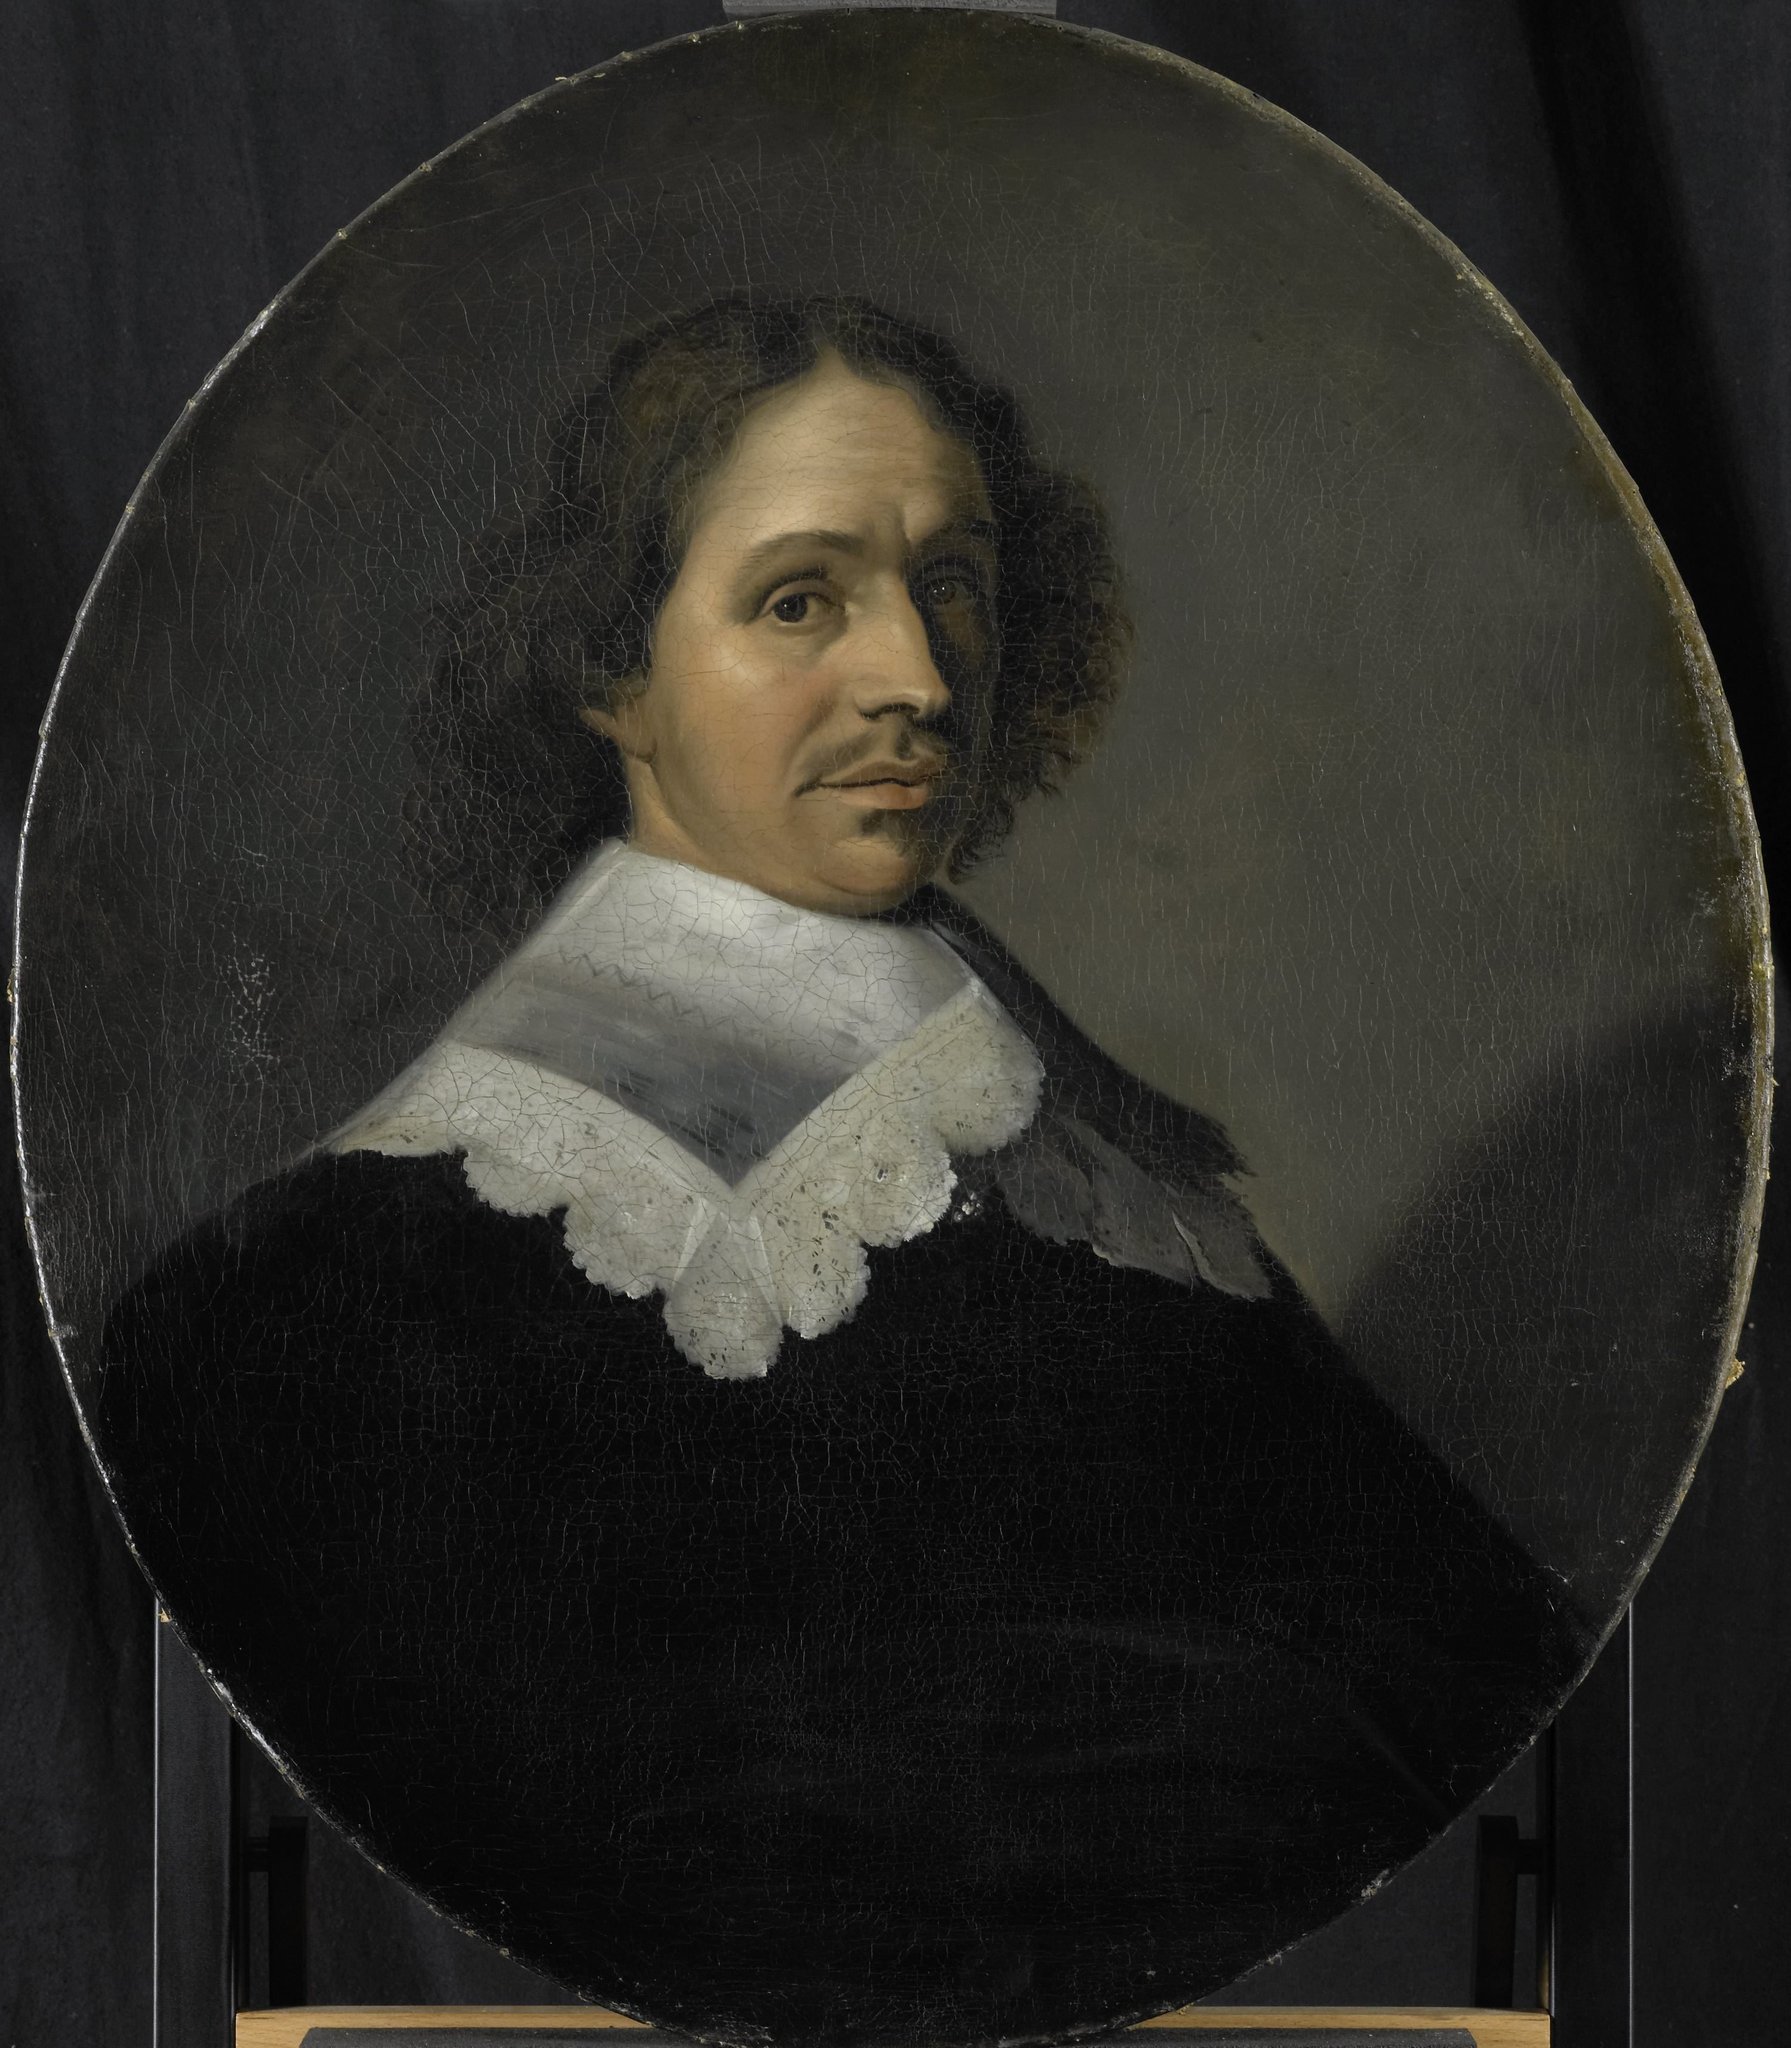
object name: painting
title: Portrait of Paulus Verschuur, Served seven terms as Burgomaster of Rotterdam and also Director of the Rotterdam Chamber of the East India Company, elected 1651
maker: pieter van der werff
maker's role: draughtsman, painter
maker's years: 1665-1722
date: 1695-1722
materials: canvas, oil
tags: rotterdam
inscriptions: inscription: ‘16 Paulus Verschuur. 51’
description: Portret van Paulus Verschuur (1606-67), gekozen in 1651. Koopman en meerdere malen burgemeester van Rotterdam. Buste in ovaal naar rechts. Vrije kopie naar het portret van Frans Hals uit 1643 in de Metropolitan Museum of Art, New York. Onderdeel van een reeks portretten van de bewindhebbers van de Rotterdamse Kamer van de Verenigde Oost-Indische Compagnie, vervaardigd voor het Nieuw Oost-Indisch Huis uit 1698 aan de Boompjes te Rotterdam.